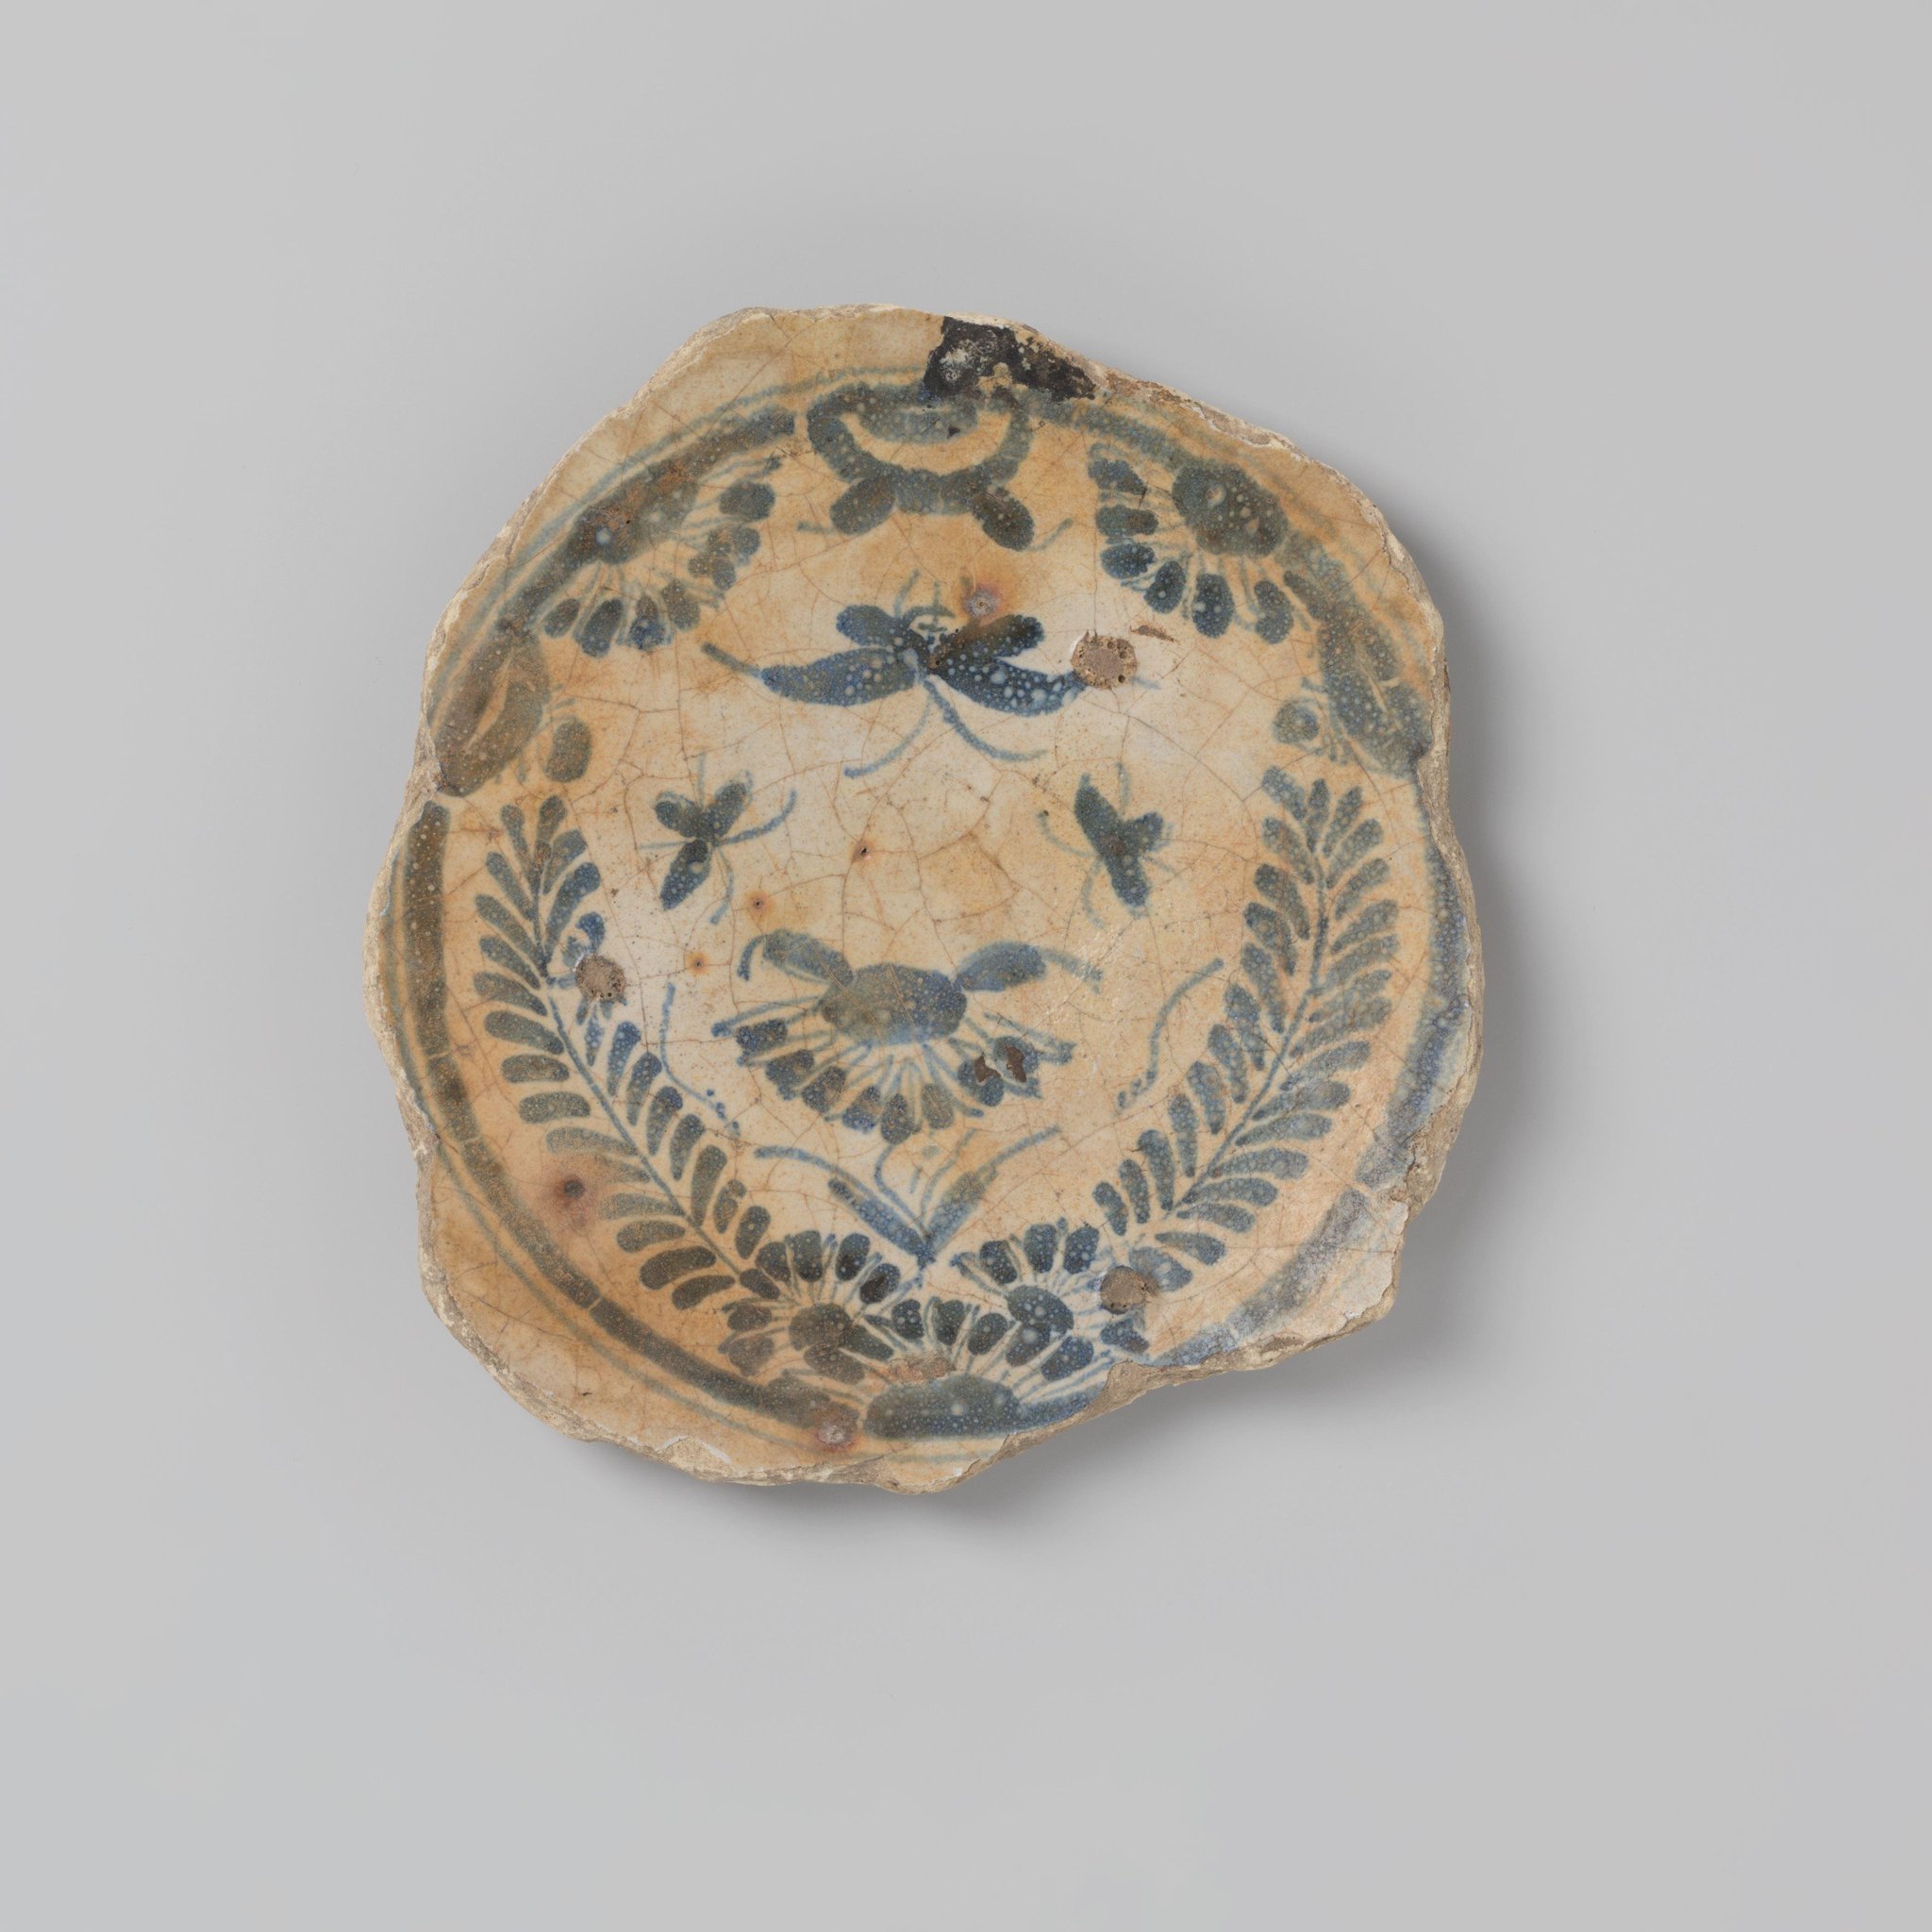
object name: sherd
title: Schotelscherf van aardewerk met tekening van vogels, bloemen en insecten, in onderglazuur blauw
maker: Anonymous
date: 1500-1799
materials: earthenware, glaze